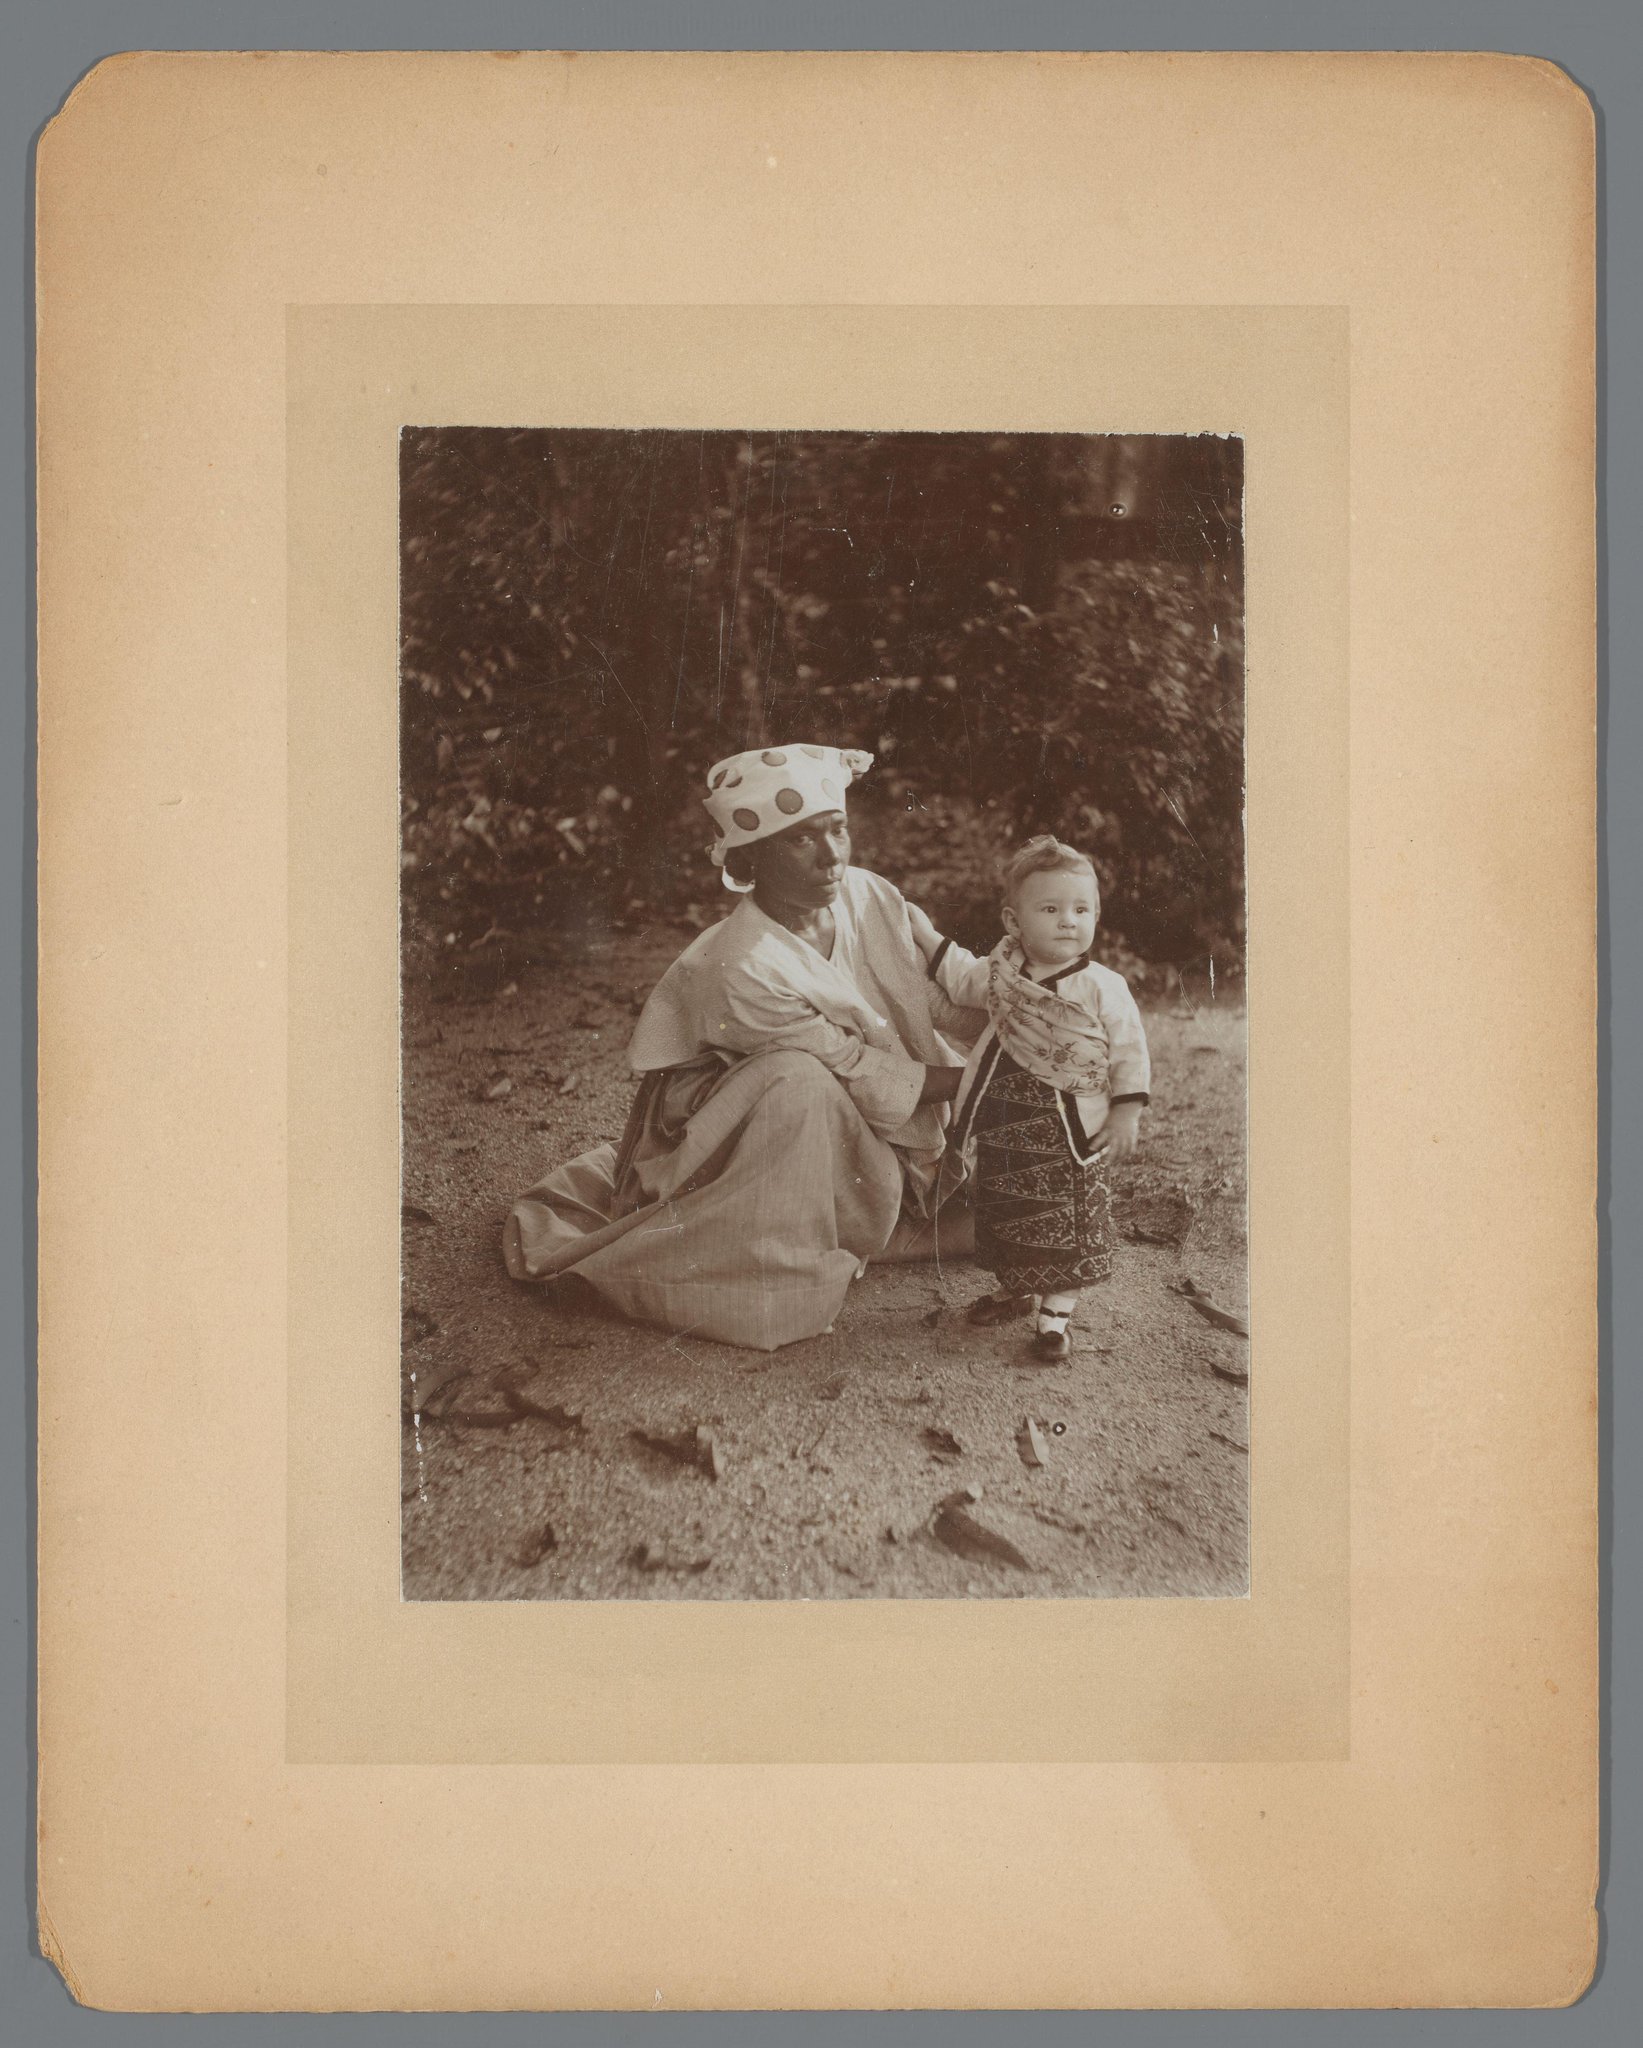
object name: photograph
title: Portret van Rose Charlotte van Lelyveld met haar Surinaamse kindermeisje Sara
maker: théodore van lelyveld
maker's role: painter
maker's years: 1867-1954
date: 1898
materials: paper, cardboard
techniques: collodion silver print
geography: paramaribo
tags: arnhem, baby-sitter, historical persons - bb - woman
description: Portret van Rose Ch. van Lelyveld, dochter van Théodore Bernard van Lelyveld, met haar Surinaamse kindermeisje Sara (achternaam onbekend), Paramaribo.